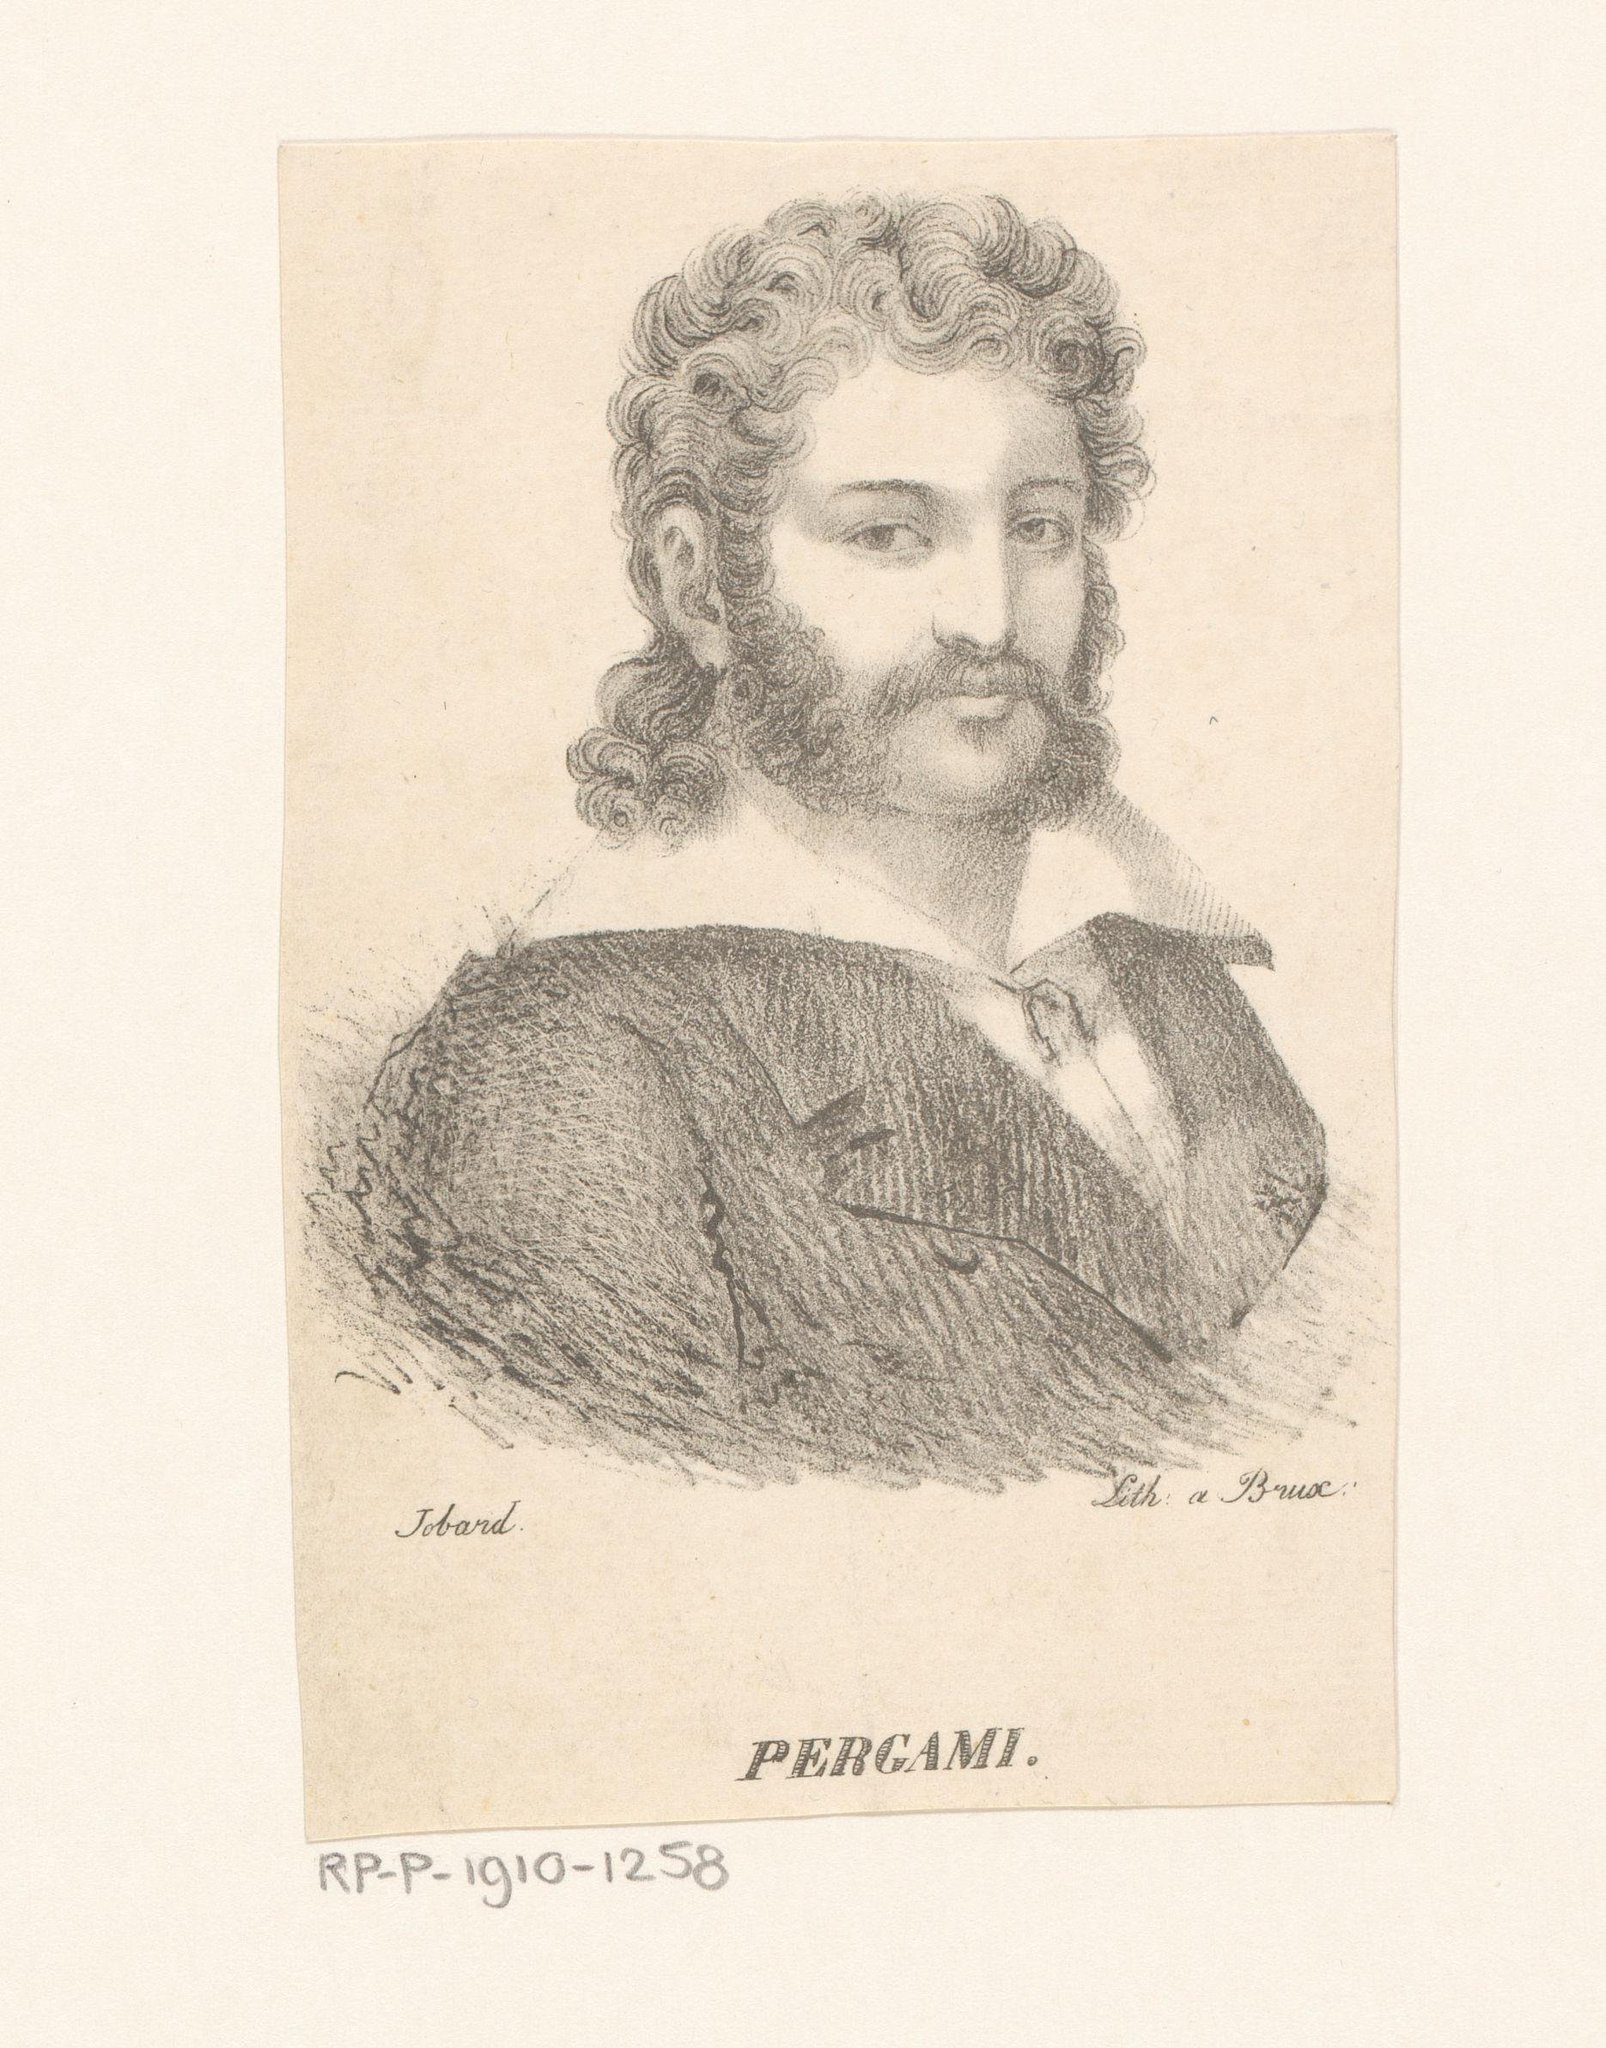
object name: book illustration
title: Portret van Bartolomeo Bergami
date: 1821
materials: paper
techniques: lithograph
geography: the hague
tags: earl, historical persons, manservant, footman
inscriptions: collector's mark: Lugt 2228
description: Prent uit: Almertè, Tarmini. Reizen van Hare Majesteit, de Koningin van Engeland, en van den Baron Pergami, haren Kamerheer, door Duitschland, Italië, Griekenland (...) waarin zeer vele belangrijke en wetenswaardige gebeurtenissen voorkomen. Den Haag: M. de Lyon, 1821.